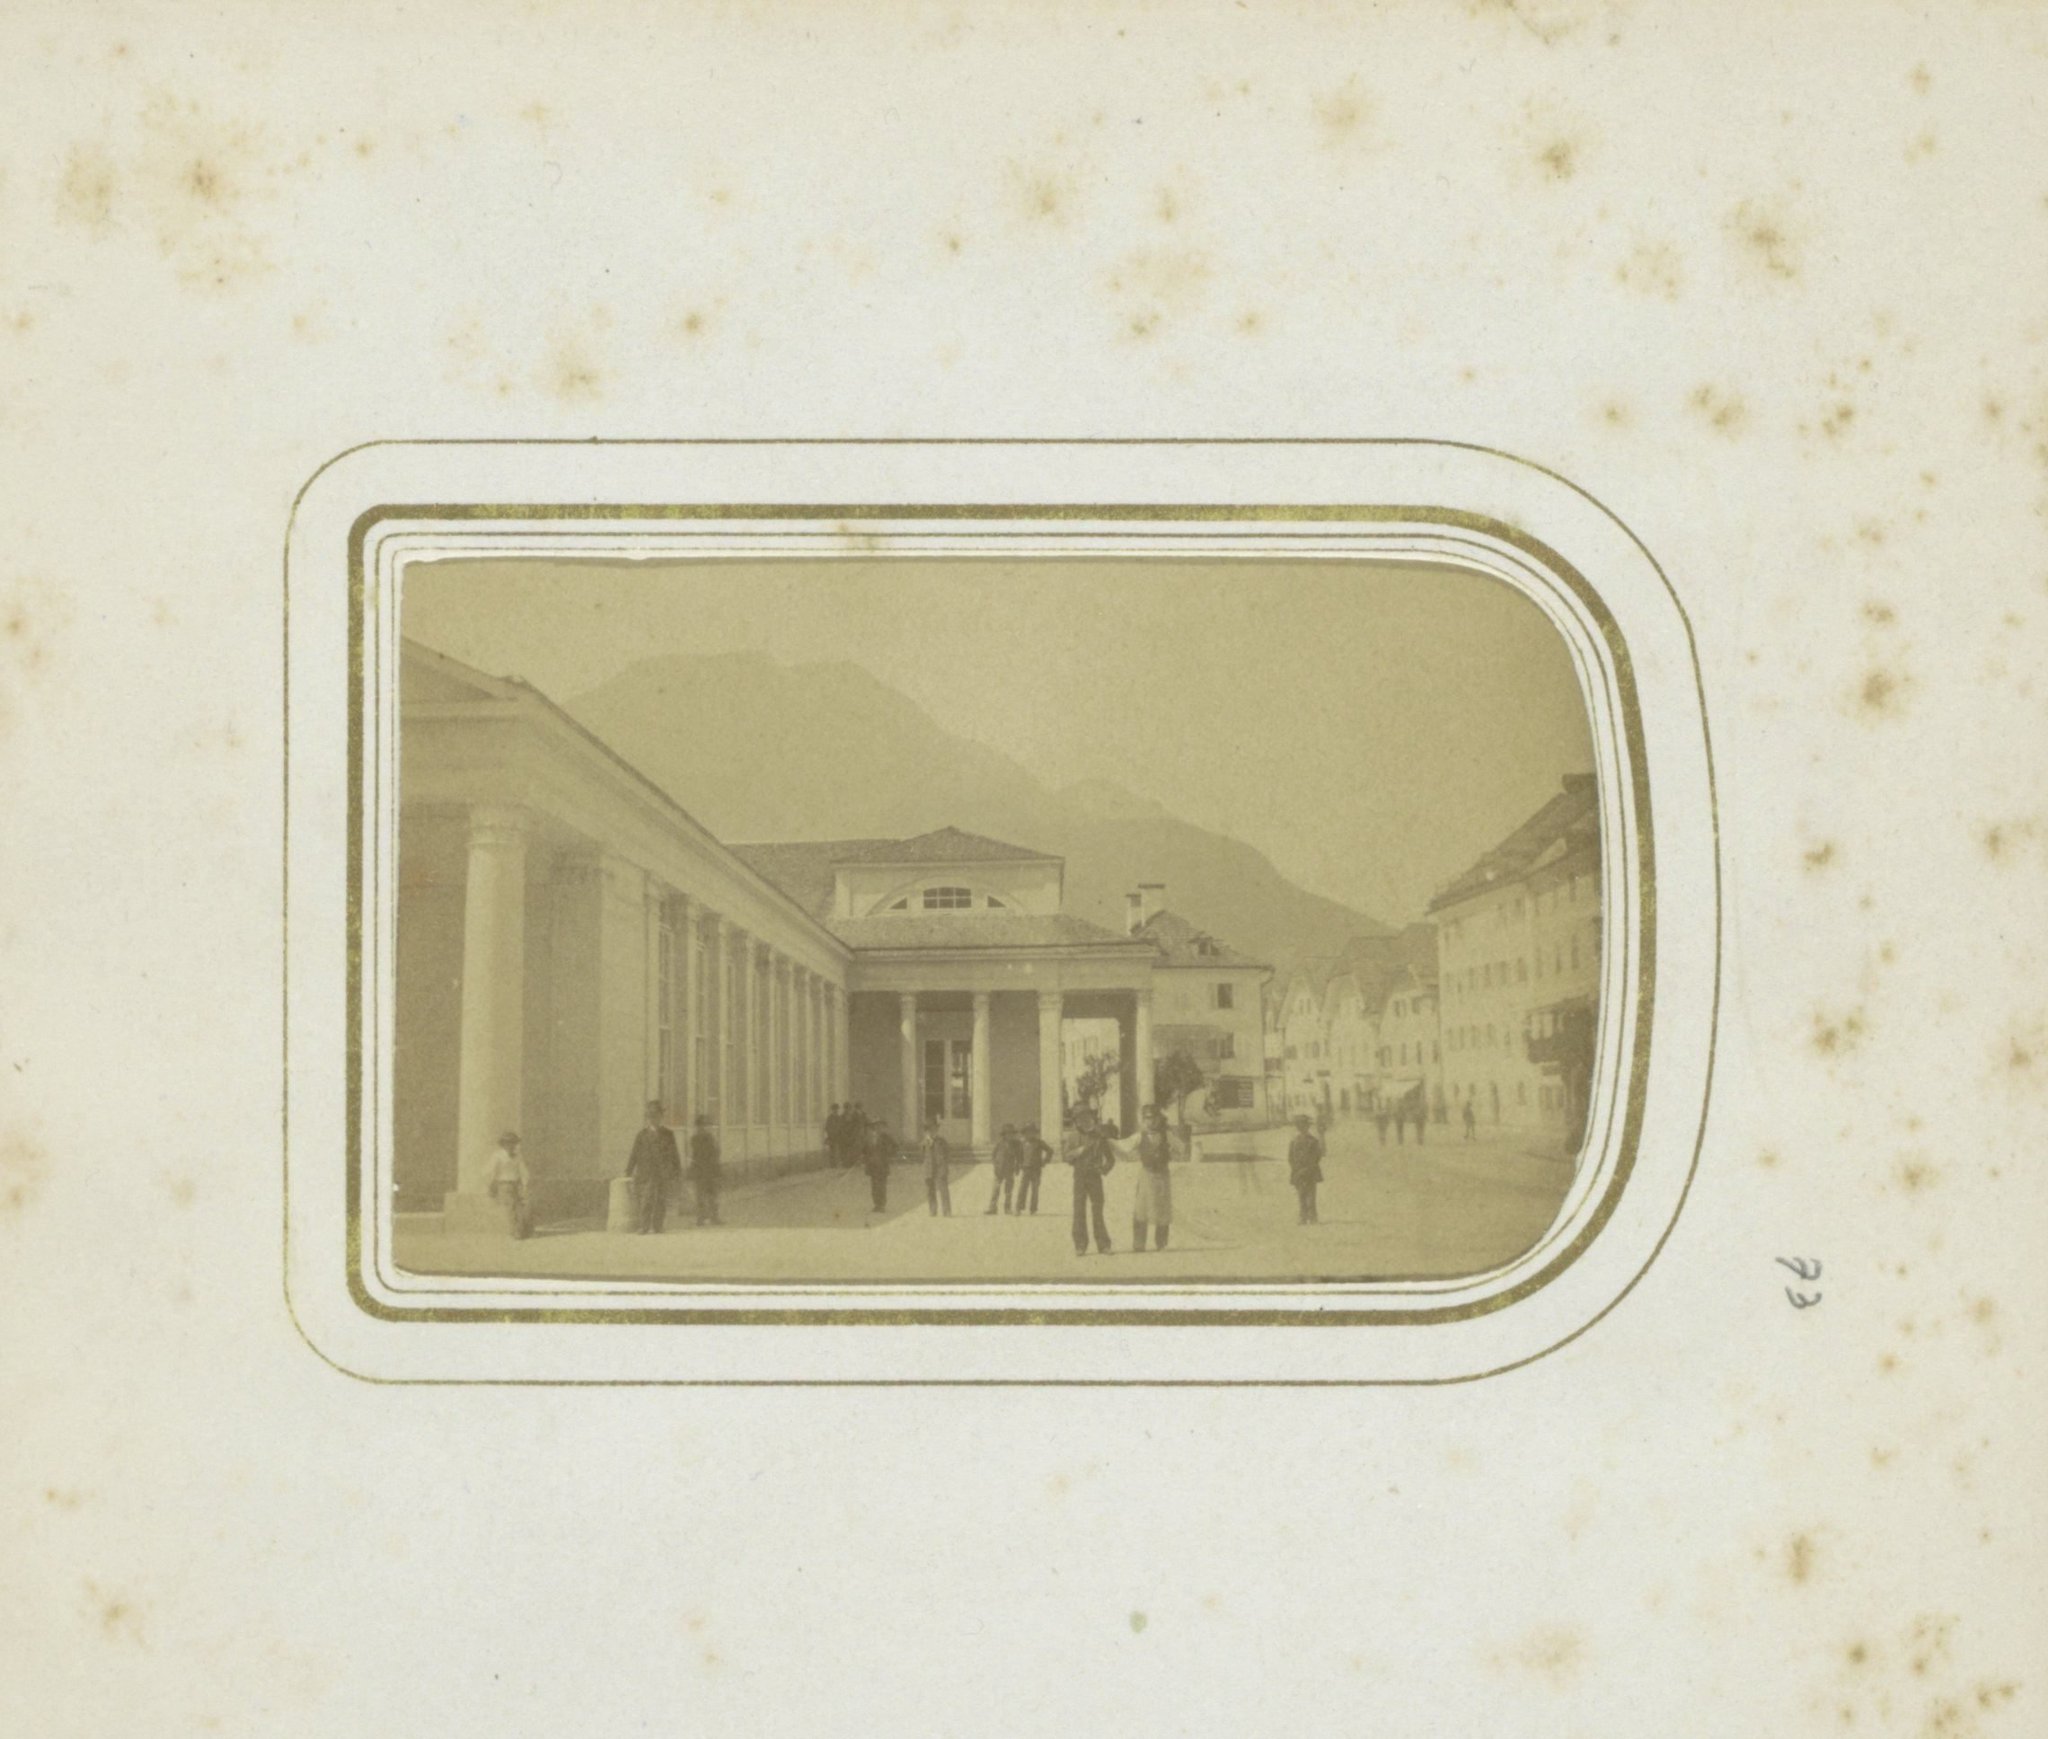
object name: photograph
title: Mensen op straat bij het casino in Ischl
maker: Anonymous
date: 1865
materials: paper, photographic support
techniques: albumen print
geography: ischl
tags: watering-place, spa, travelling; tourism, casino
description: Onderdeel van Fotoalbum van een reis door Zwitserland, Oostenrijk en Duitsland door de Nederlandse familie Derkinderen.